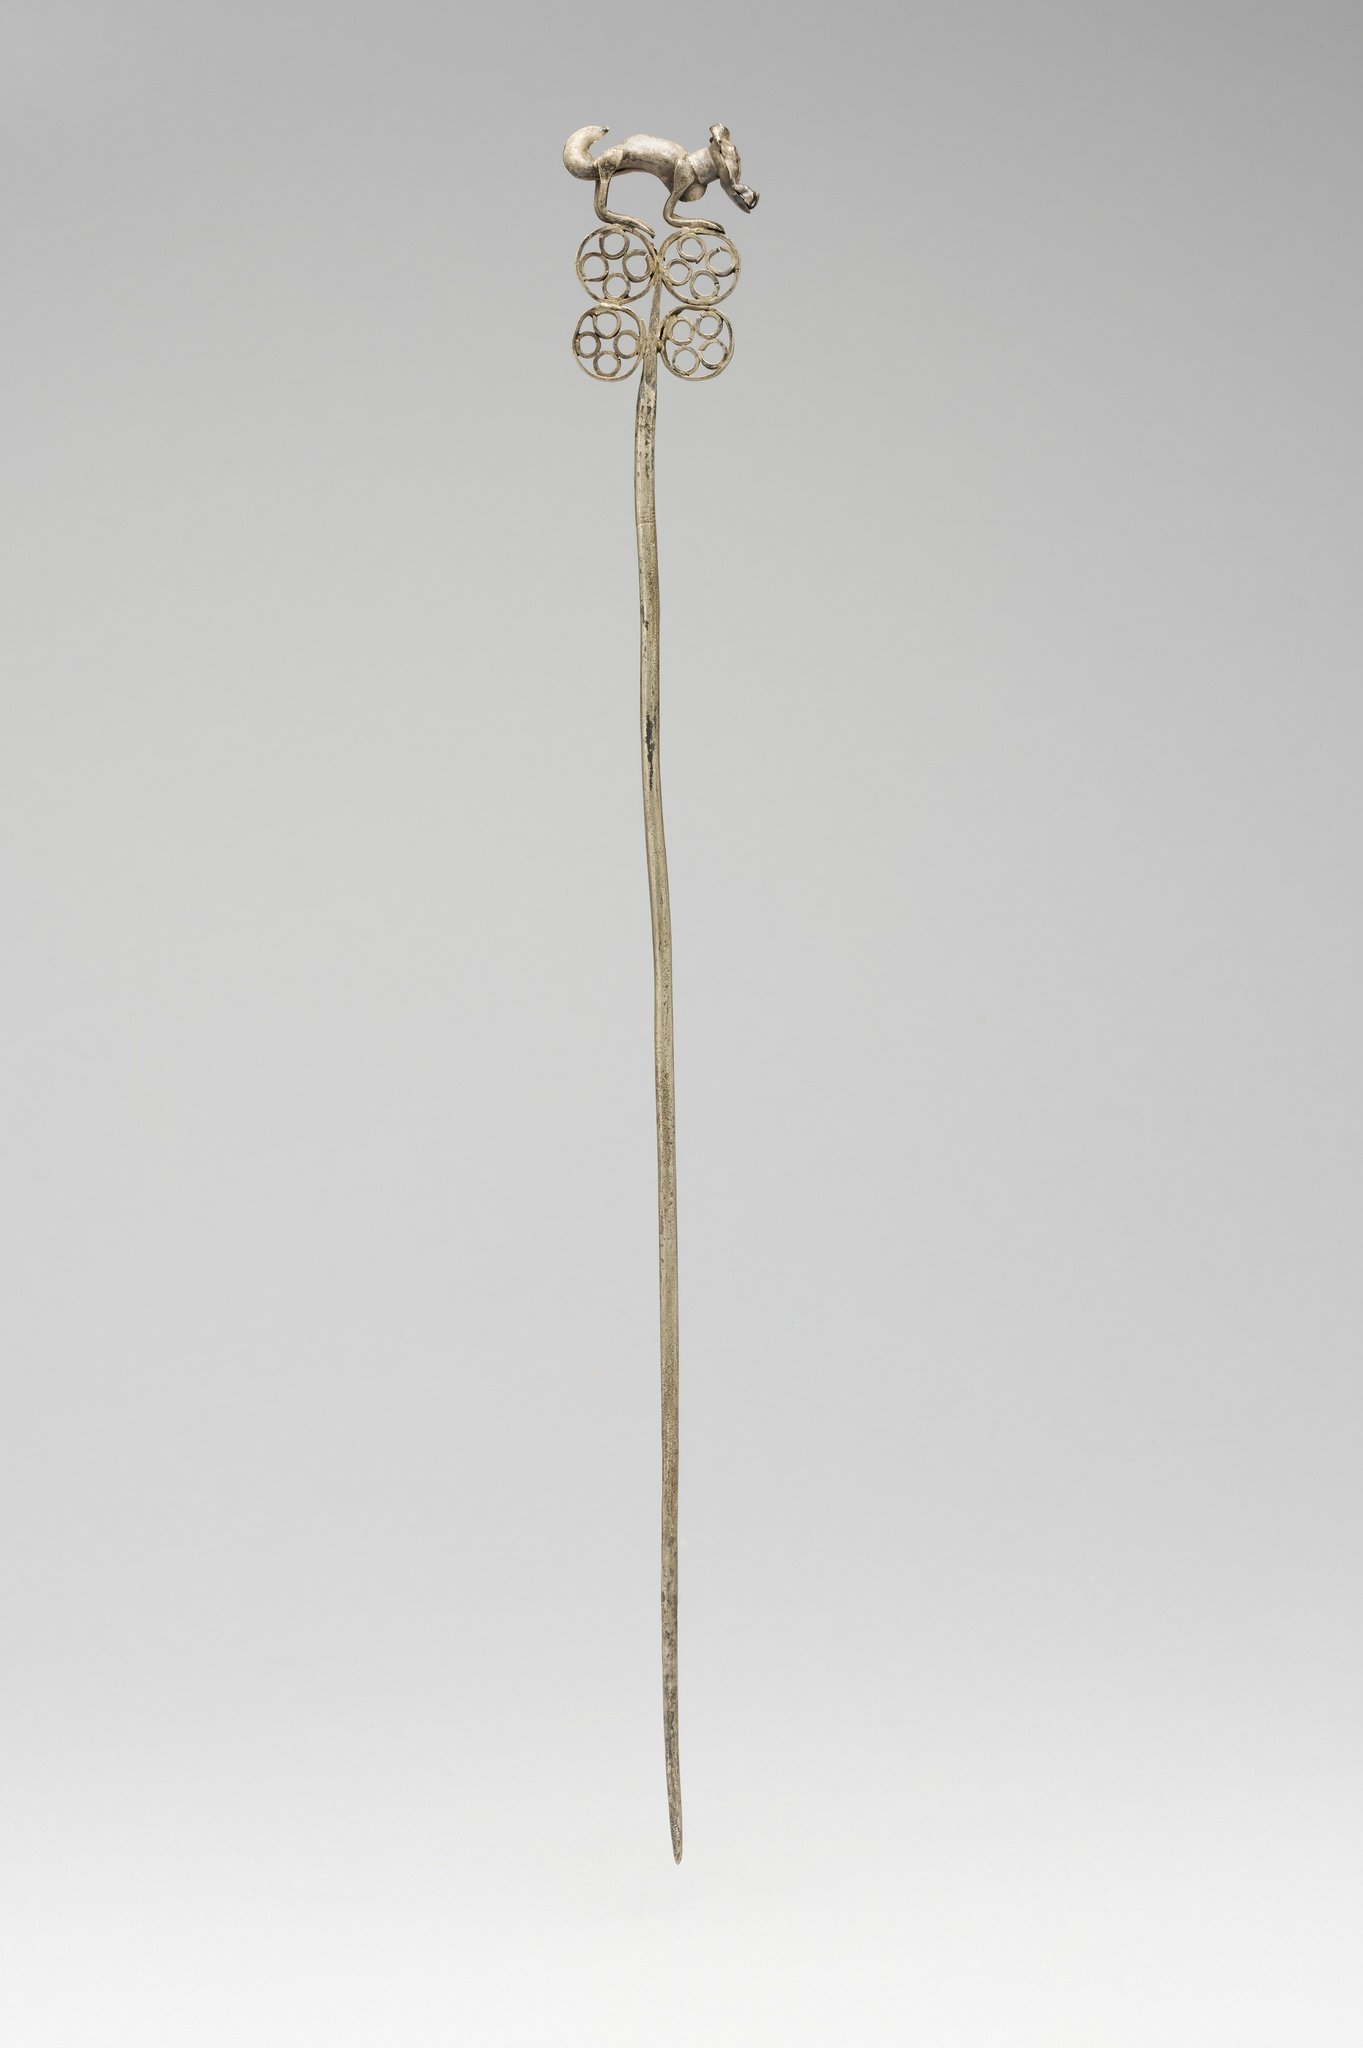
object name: pin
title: Group of pins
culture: chimú or inca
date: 1301-1500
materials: silver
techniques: hammering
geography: peru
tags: animals